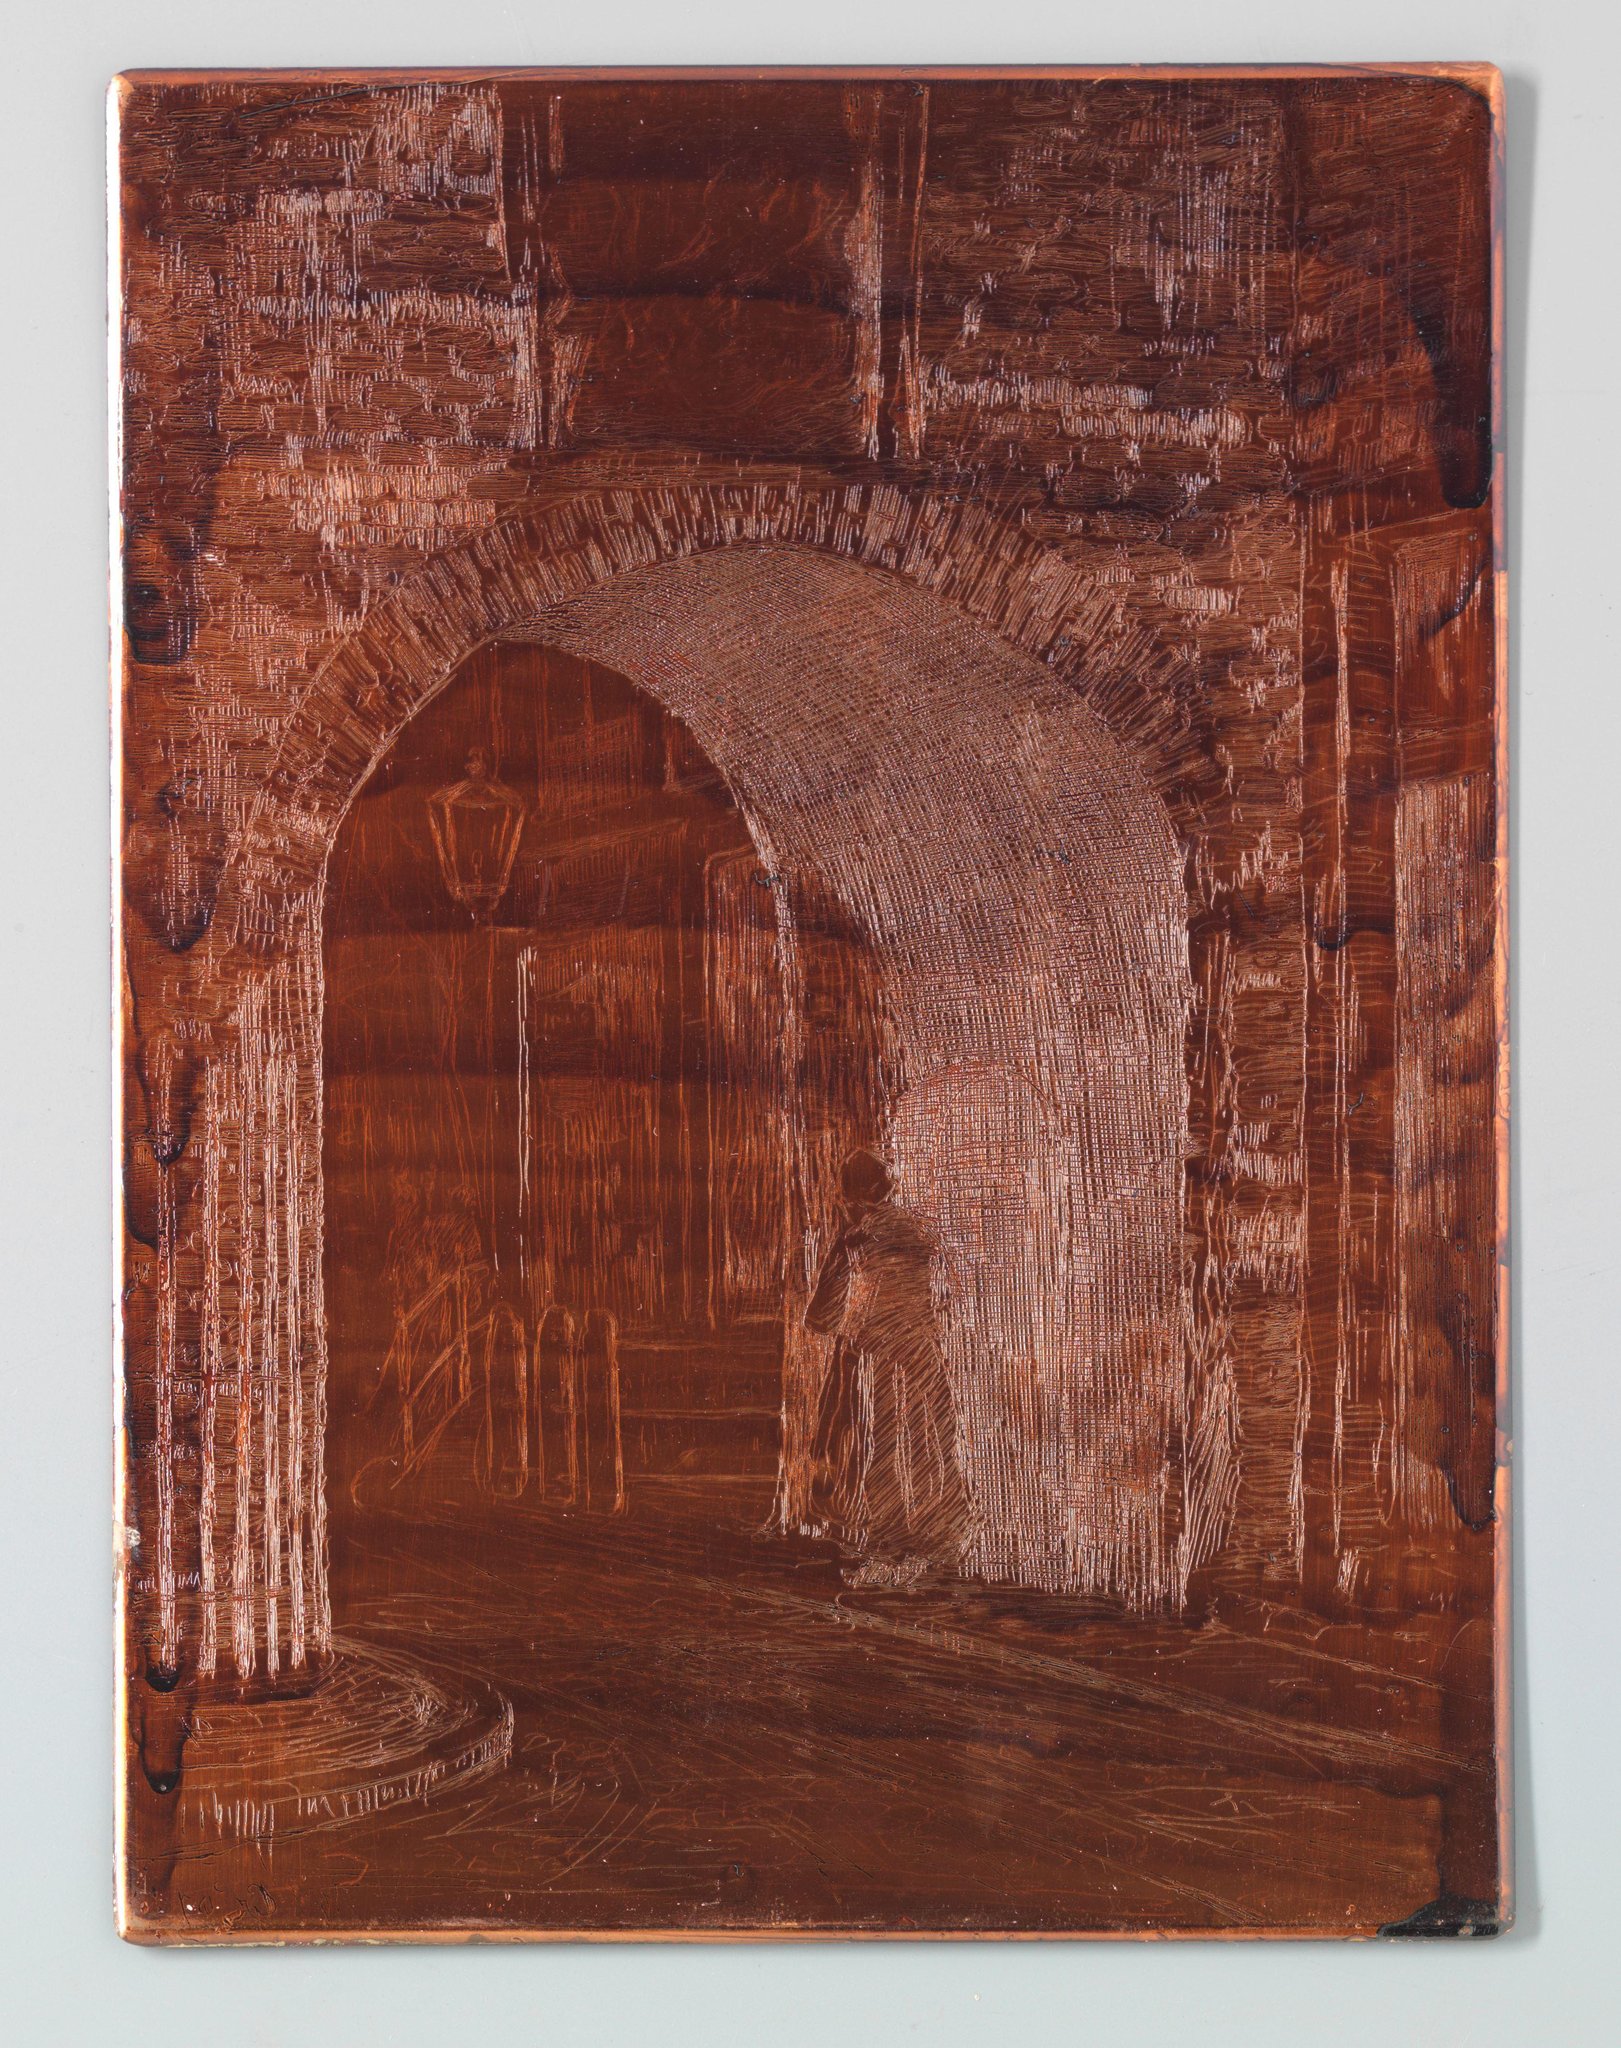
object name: copper plate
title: Gevangenispoort te Den Haag voor de restauratie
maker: willem adrianus grondhout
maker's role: draughtsman, painter, print maker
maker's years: 1878-1934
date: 1907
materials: copper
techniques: etching